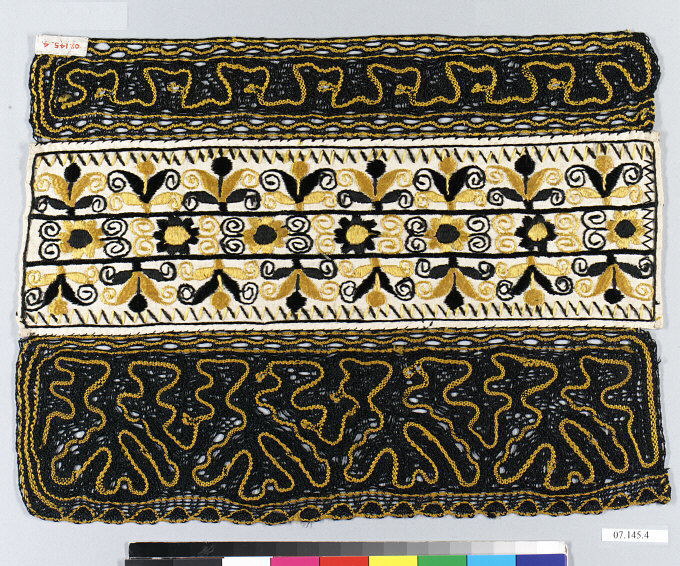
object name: cuff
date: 1801-1900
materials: thread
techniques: lace